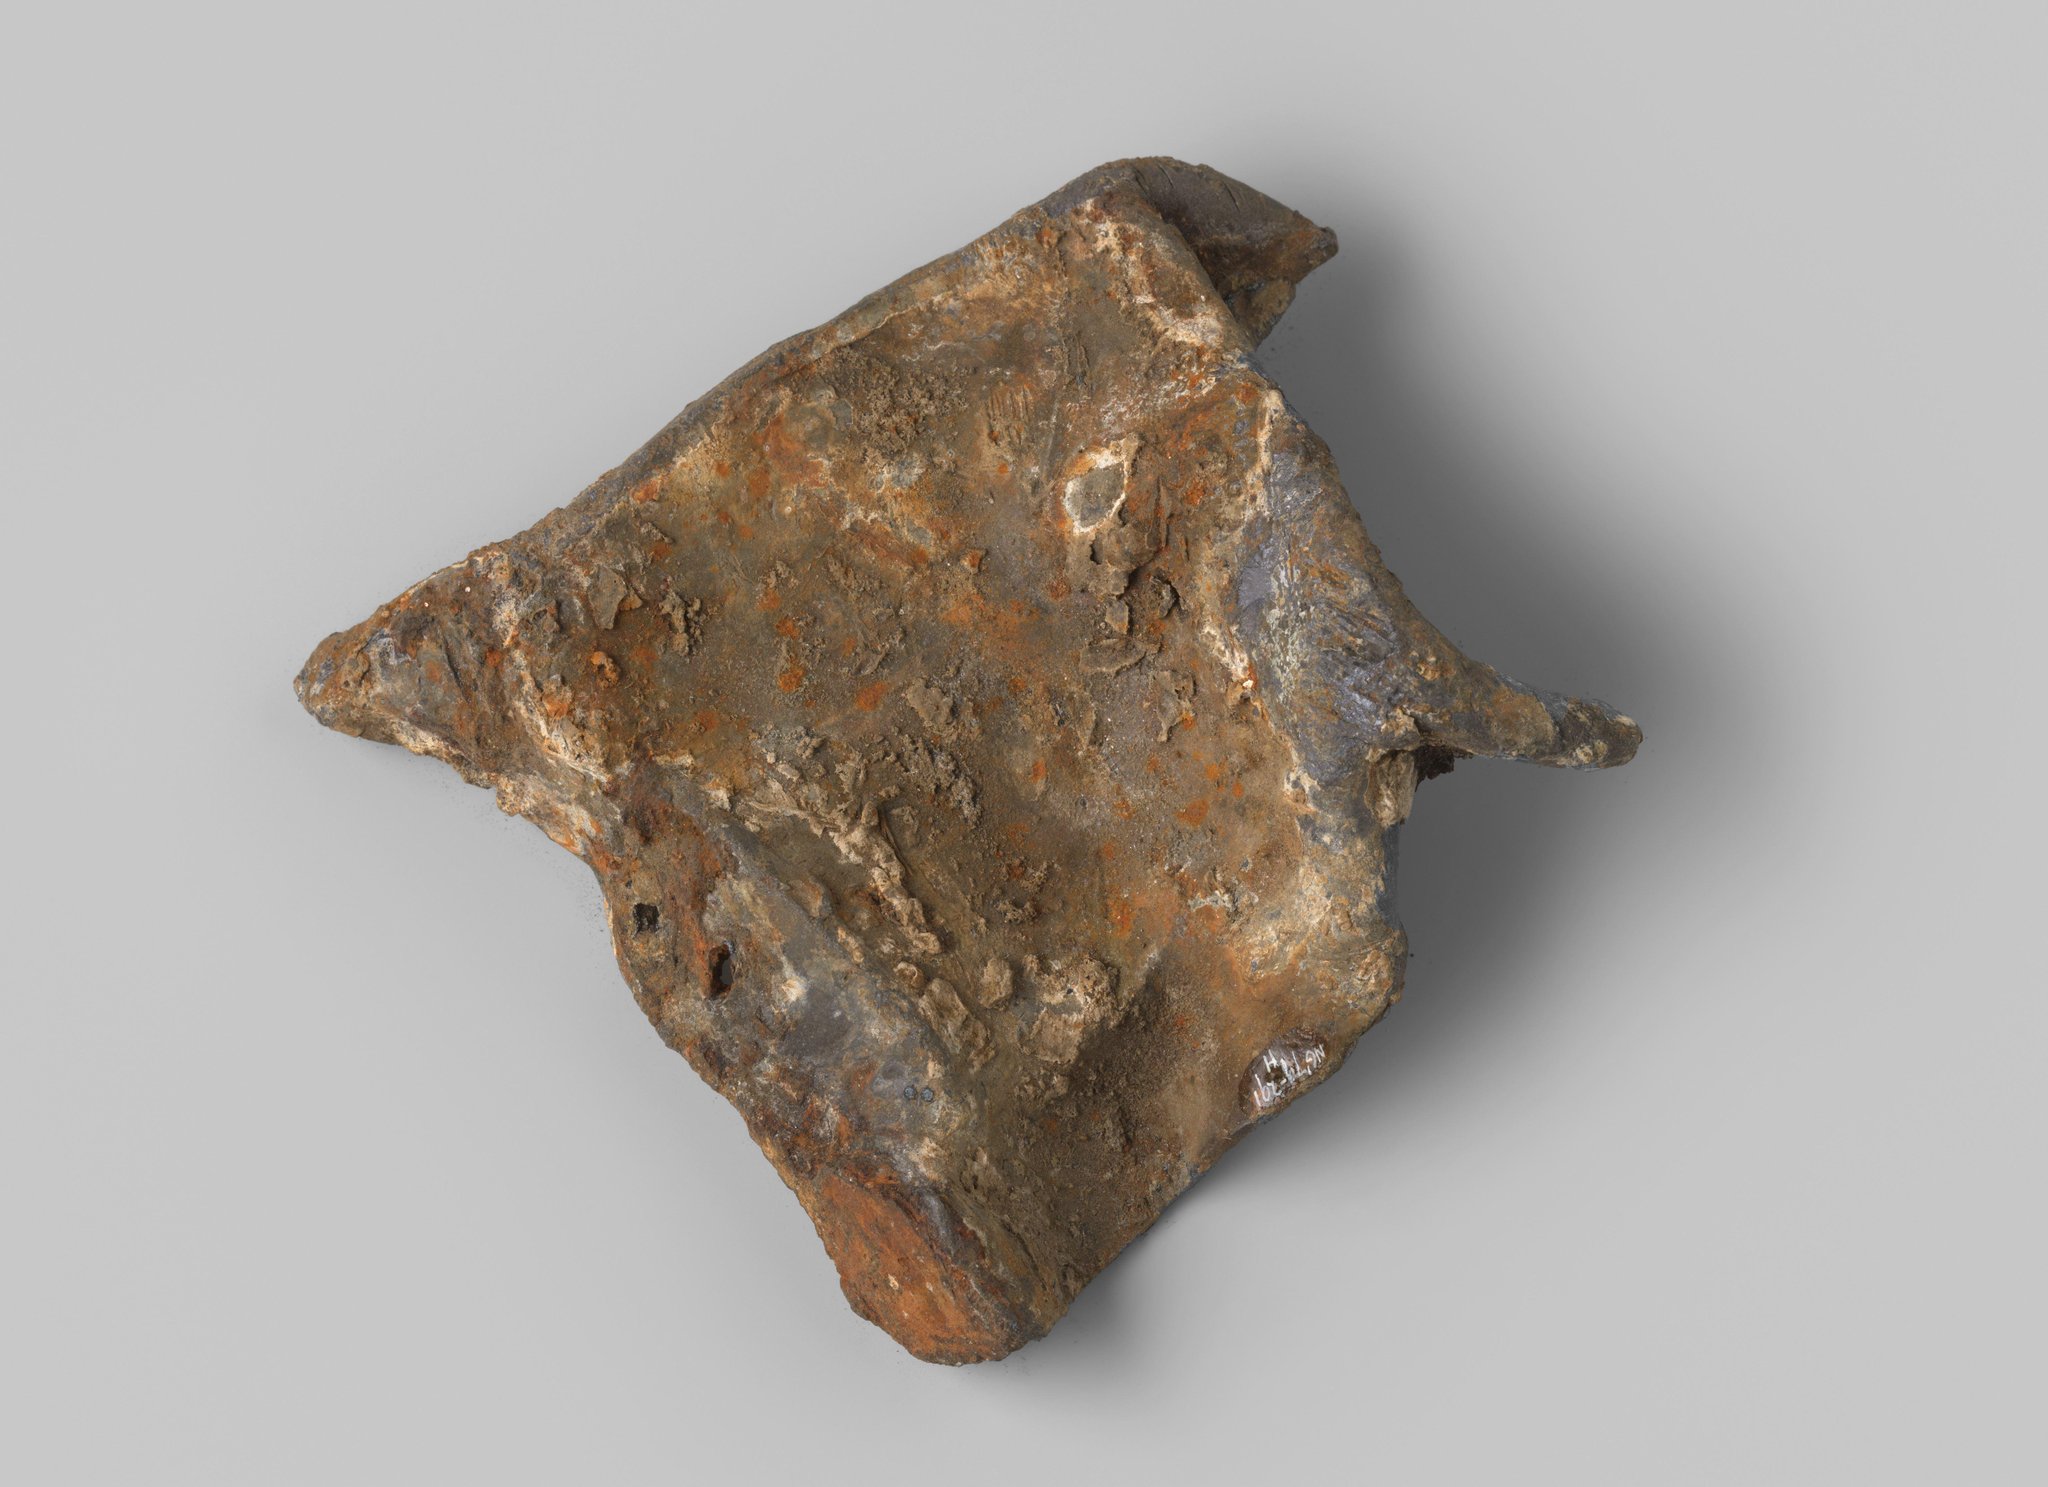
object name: oil lamp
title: Olielamp uit het wrak van de Oost-Indiëvaarder Hollandia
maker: Anonymous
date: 1700-1743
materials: lead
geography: netherlands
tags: verenigde oostindische compagnie, hollandia (schip), annet